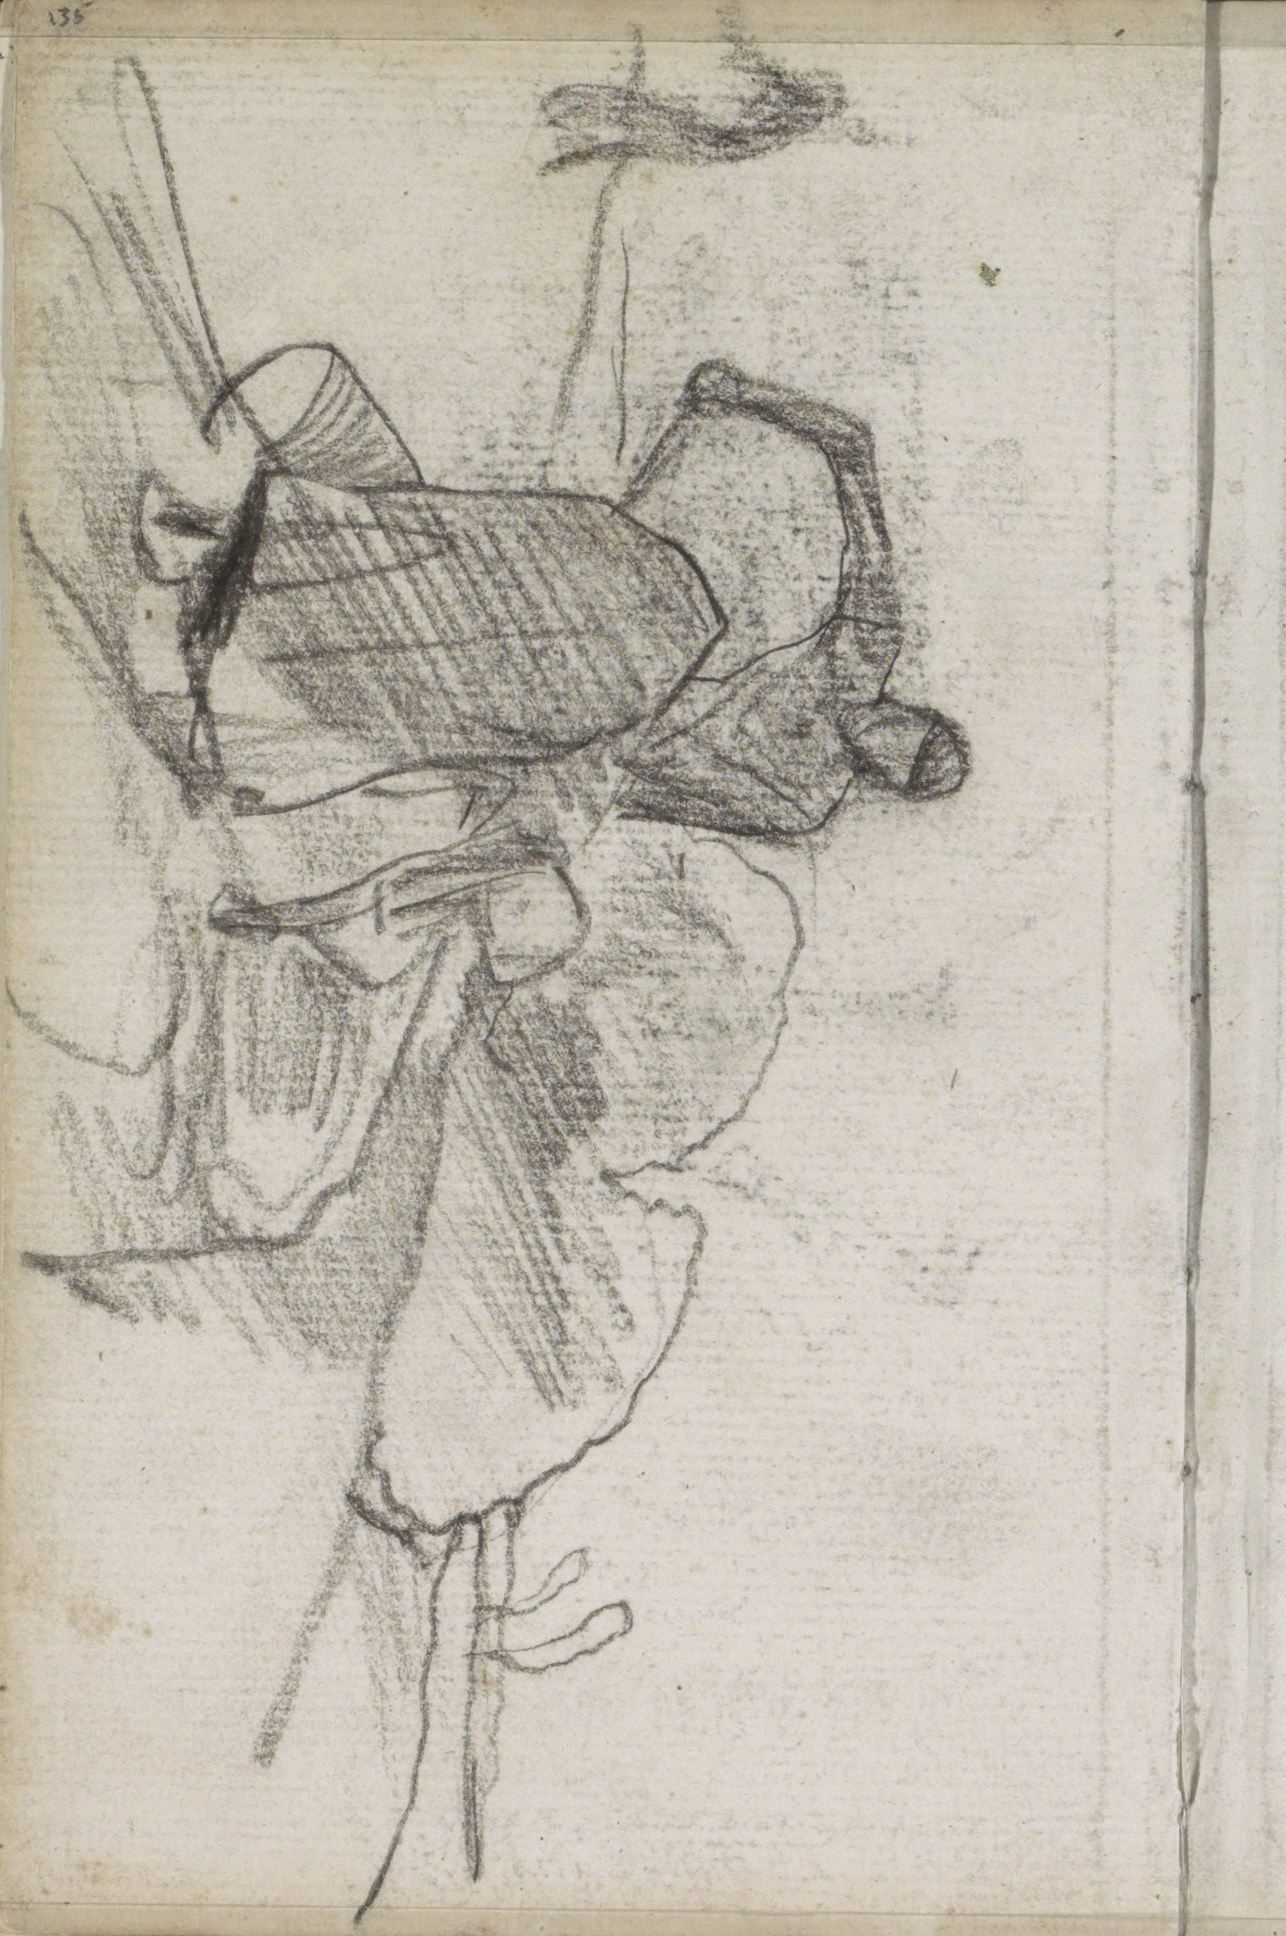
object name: sketchbook leaf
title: Boer en boerin op het land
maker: george hendrik breitner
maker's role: draughtsman, painter, print maker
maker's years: 1857-1923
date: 1884-1886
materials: chalk, paper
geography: drenthe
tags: farmers, farmers - aa - female farmer, farmer's wife, cultivated land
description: In de verte een derde figuur. Pagina 135 uit een schetsboek met 67 bladen vervaardigd in Drenthe.